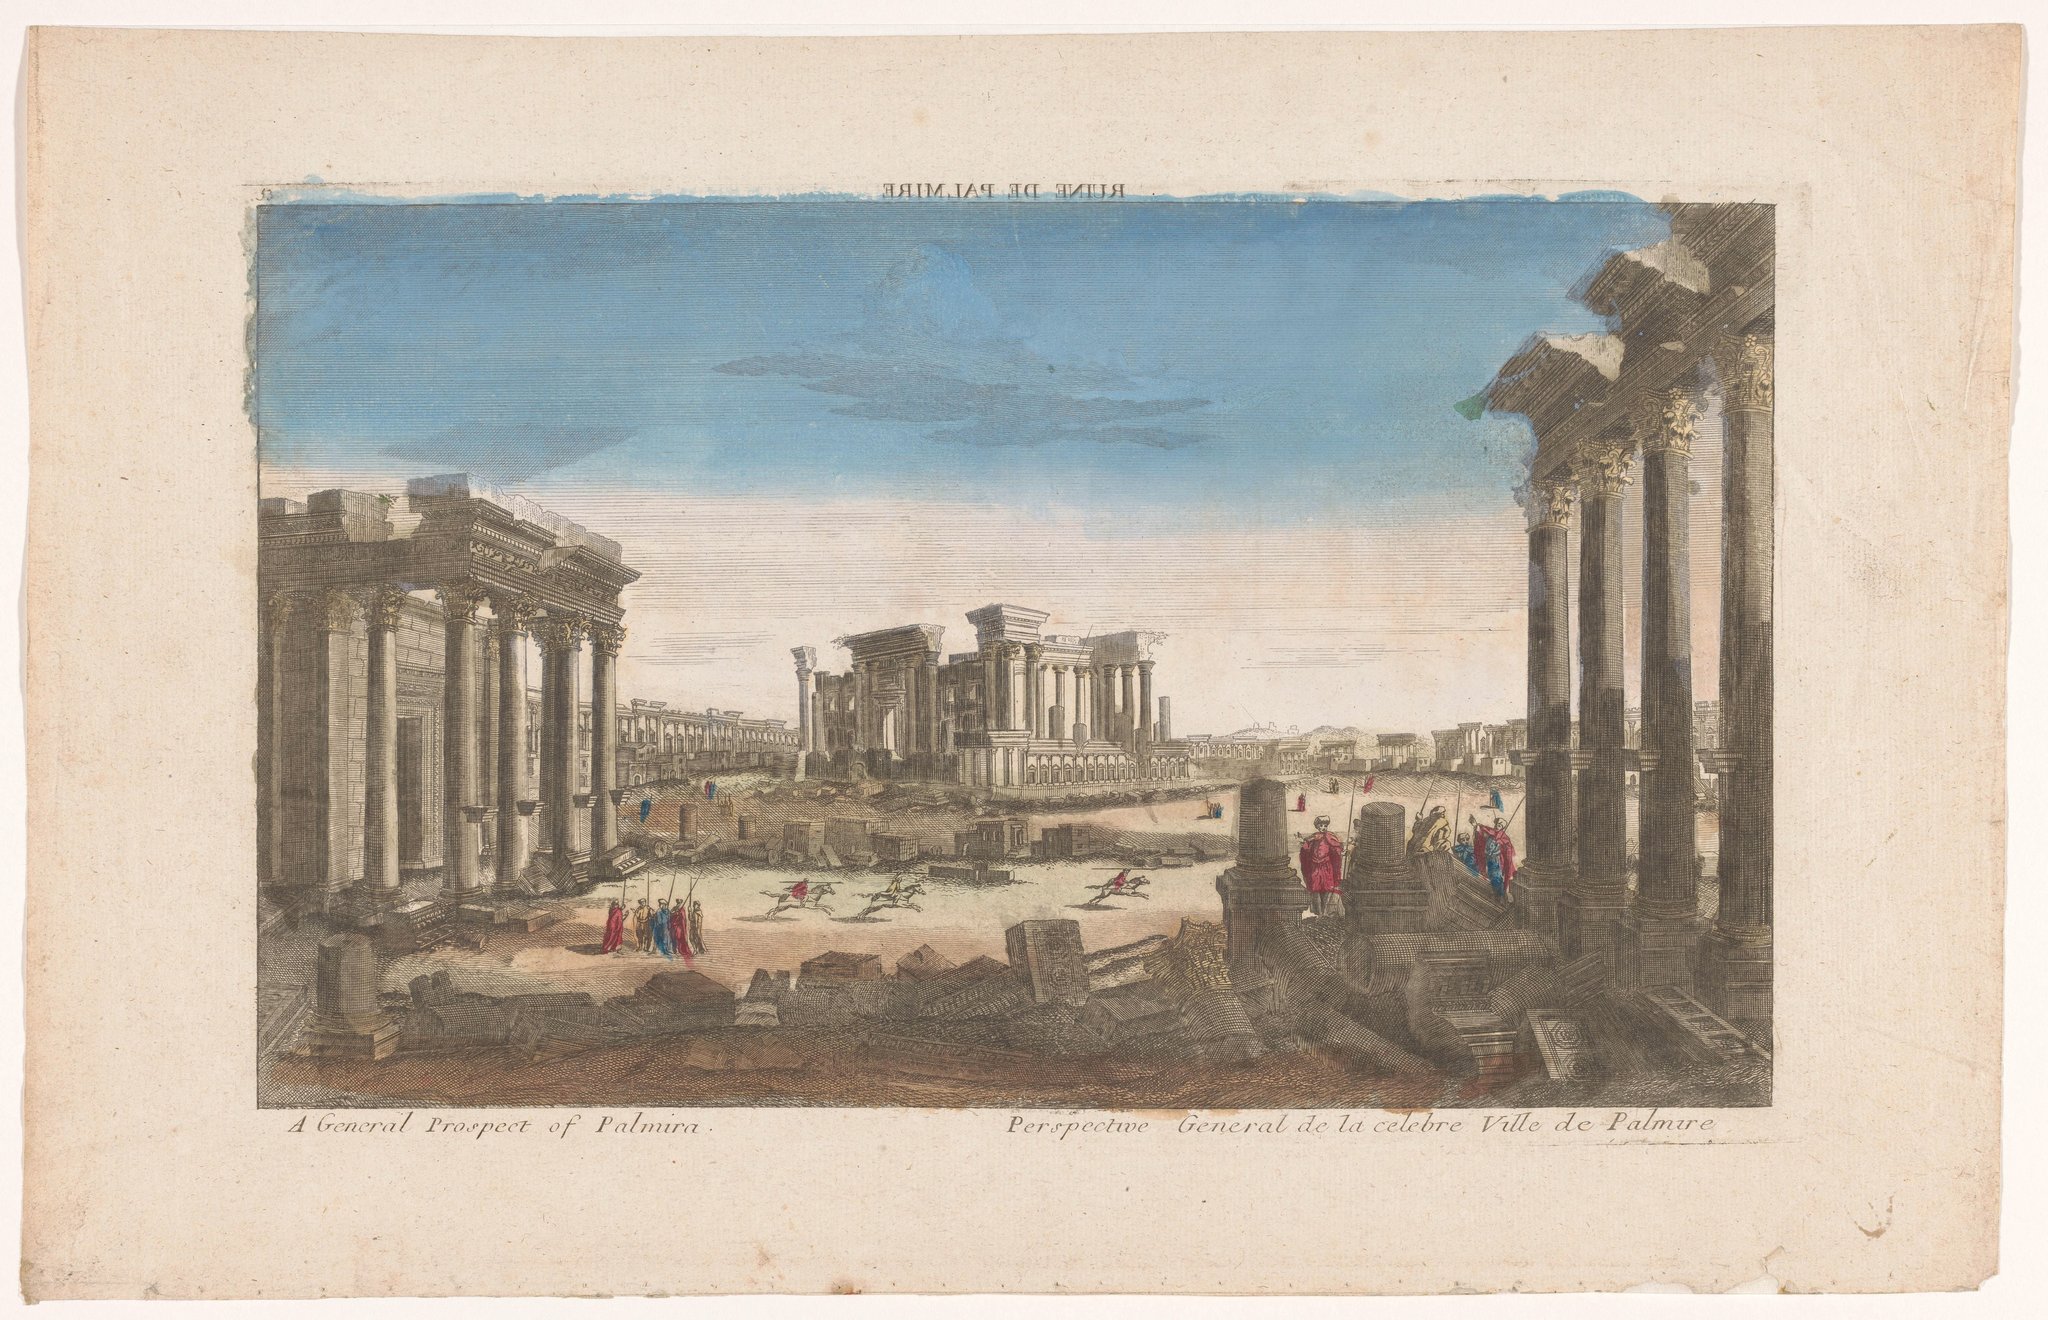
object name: print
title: Perspective general de la celebre ville de Palmire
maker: Anonymous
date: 1700-1799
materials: paper, watercolor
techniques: brush, etching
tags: colonnade, temple, shrine ~ roman religion, landscape with ruins (+ city(-scape) with figures, staffage)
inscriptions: watermark, collector's mark: Lugt 2166